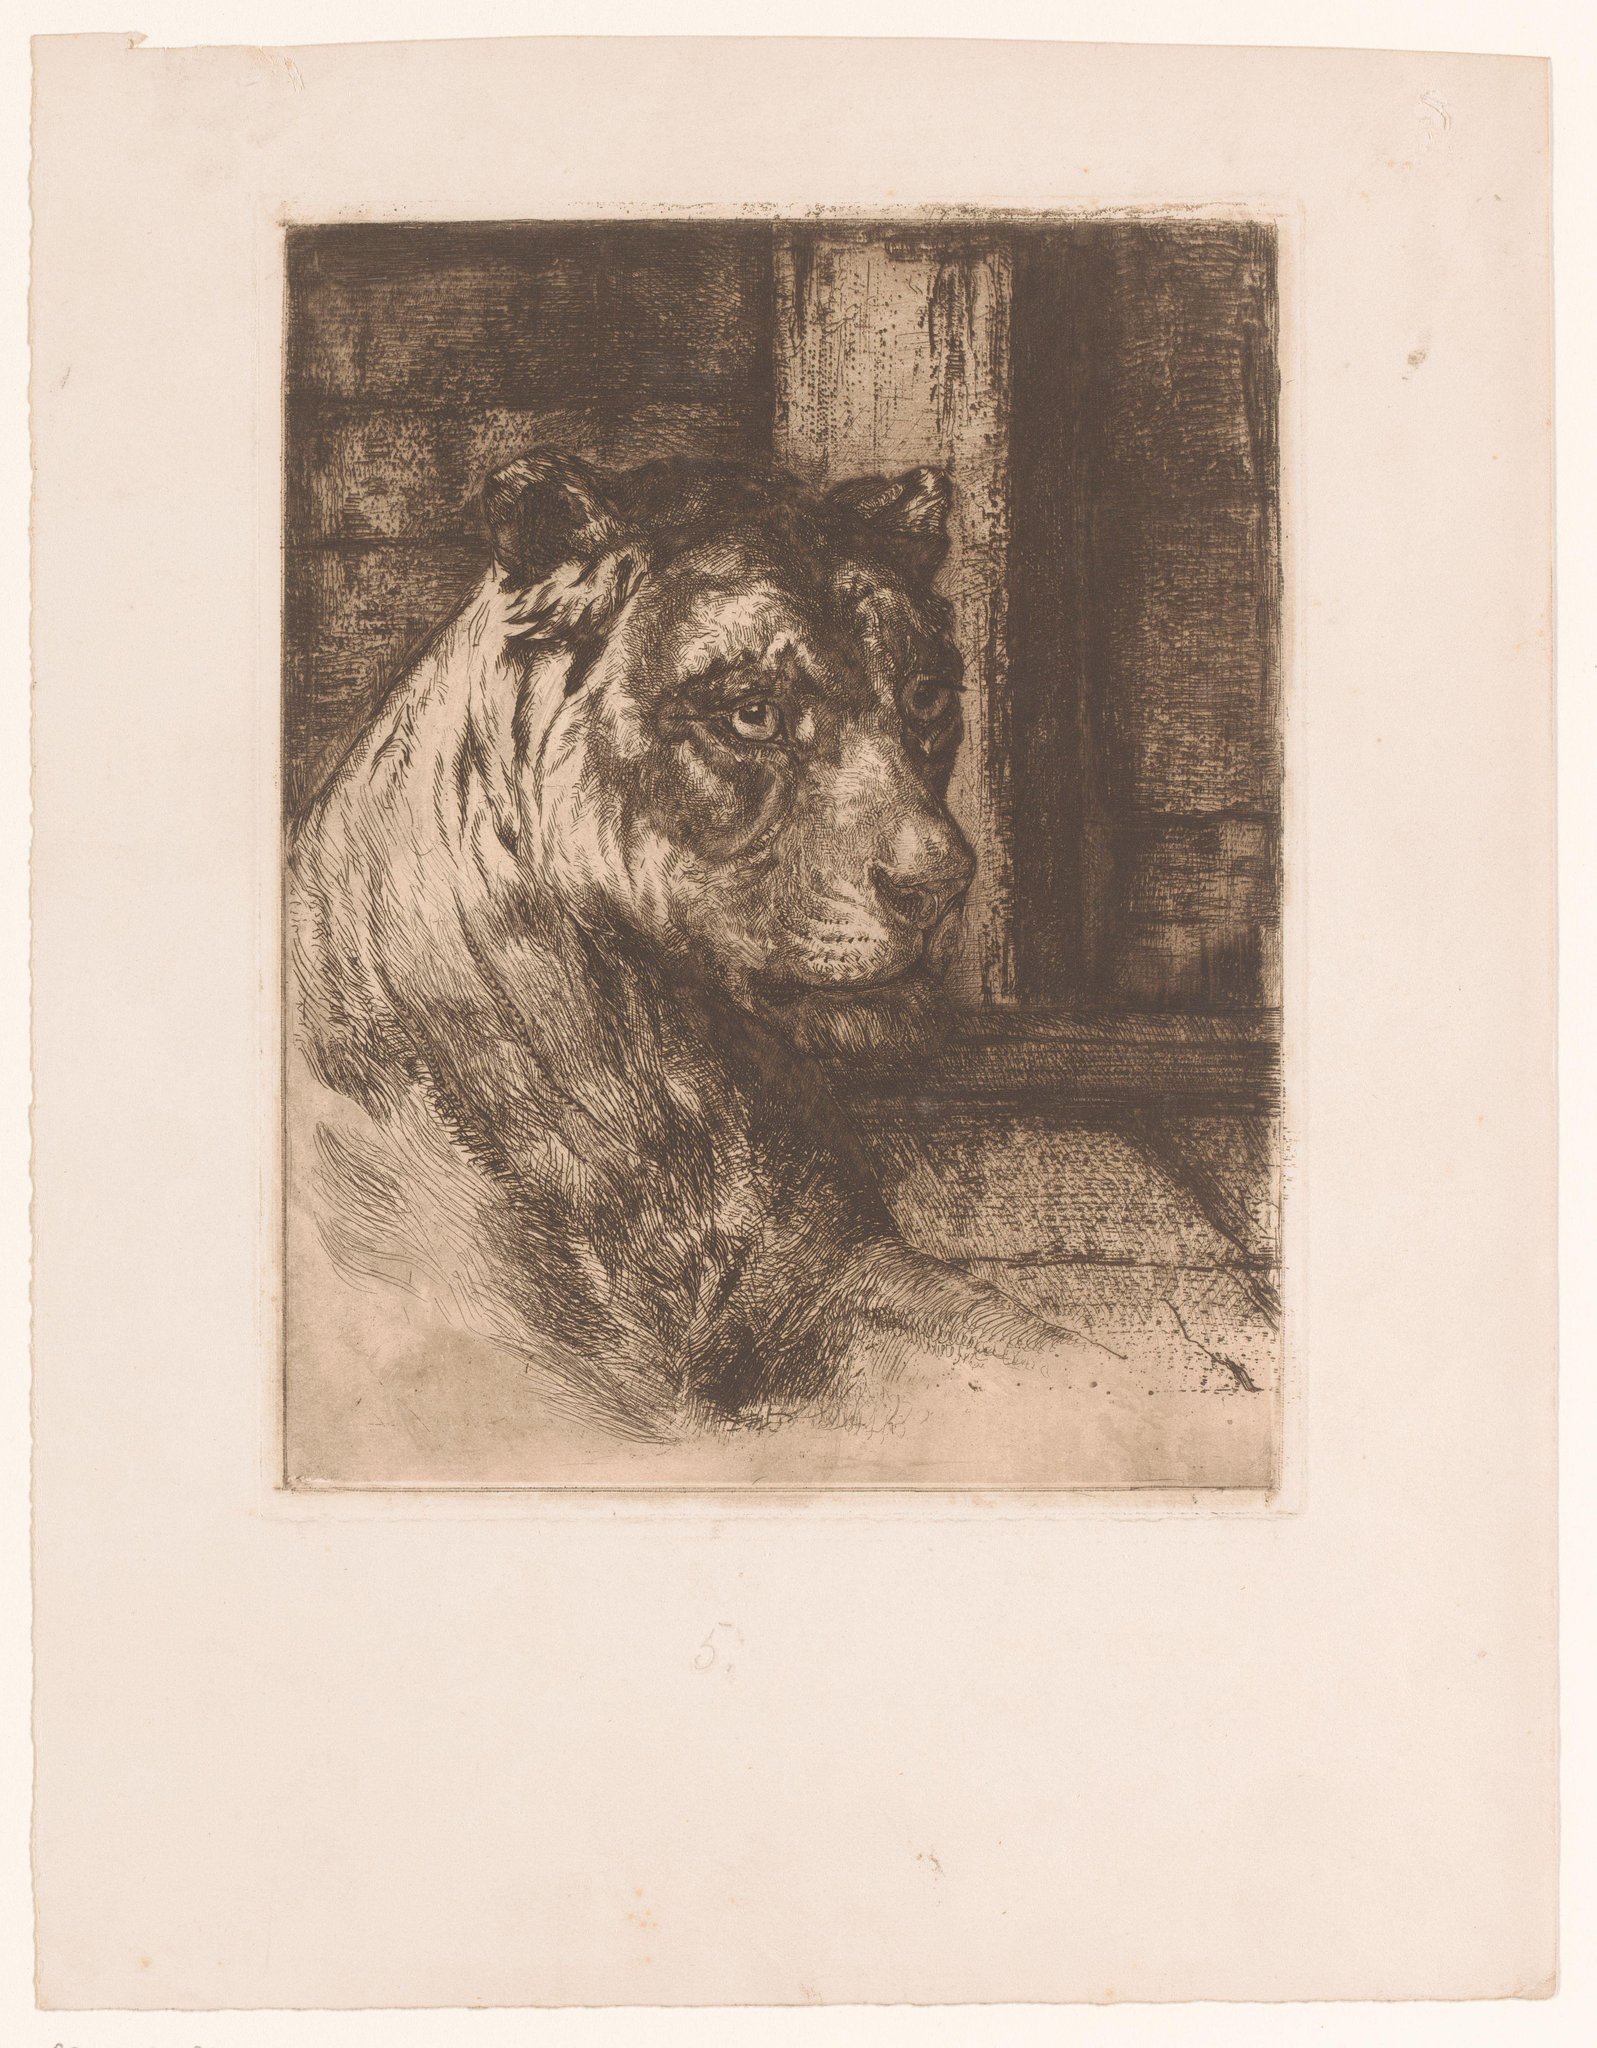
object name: print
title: Kop van een liggende leeuwin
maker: joseph schippers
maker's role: print maker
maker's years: 1868-1950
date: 1878-1913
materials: paper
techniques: etching, intaglio, retroussage, roulette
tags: beasts of prey, predatory animals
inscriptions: number: ‘5.’, collector's mark: Lugt 2228